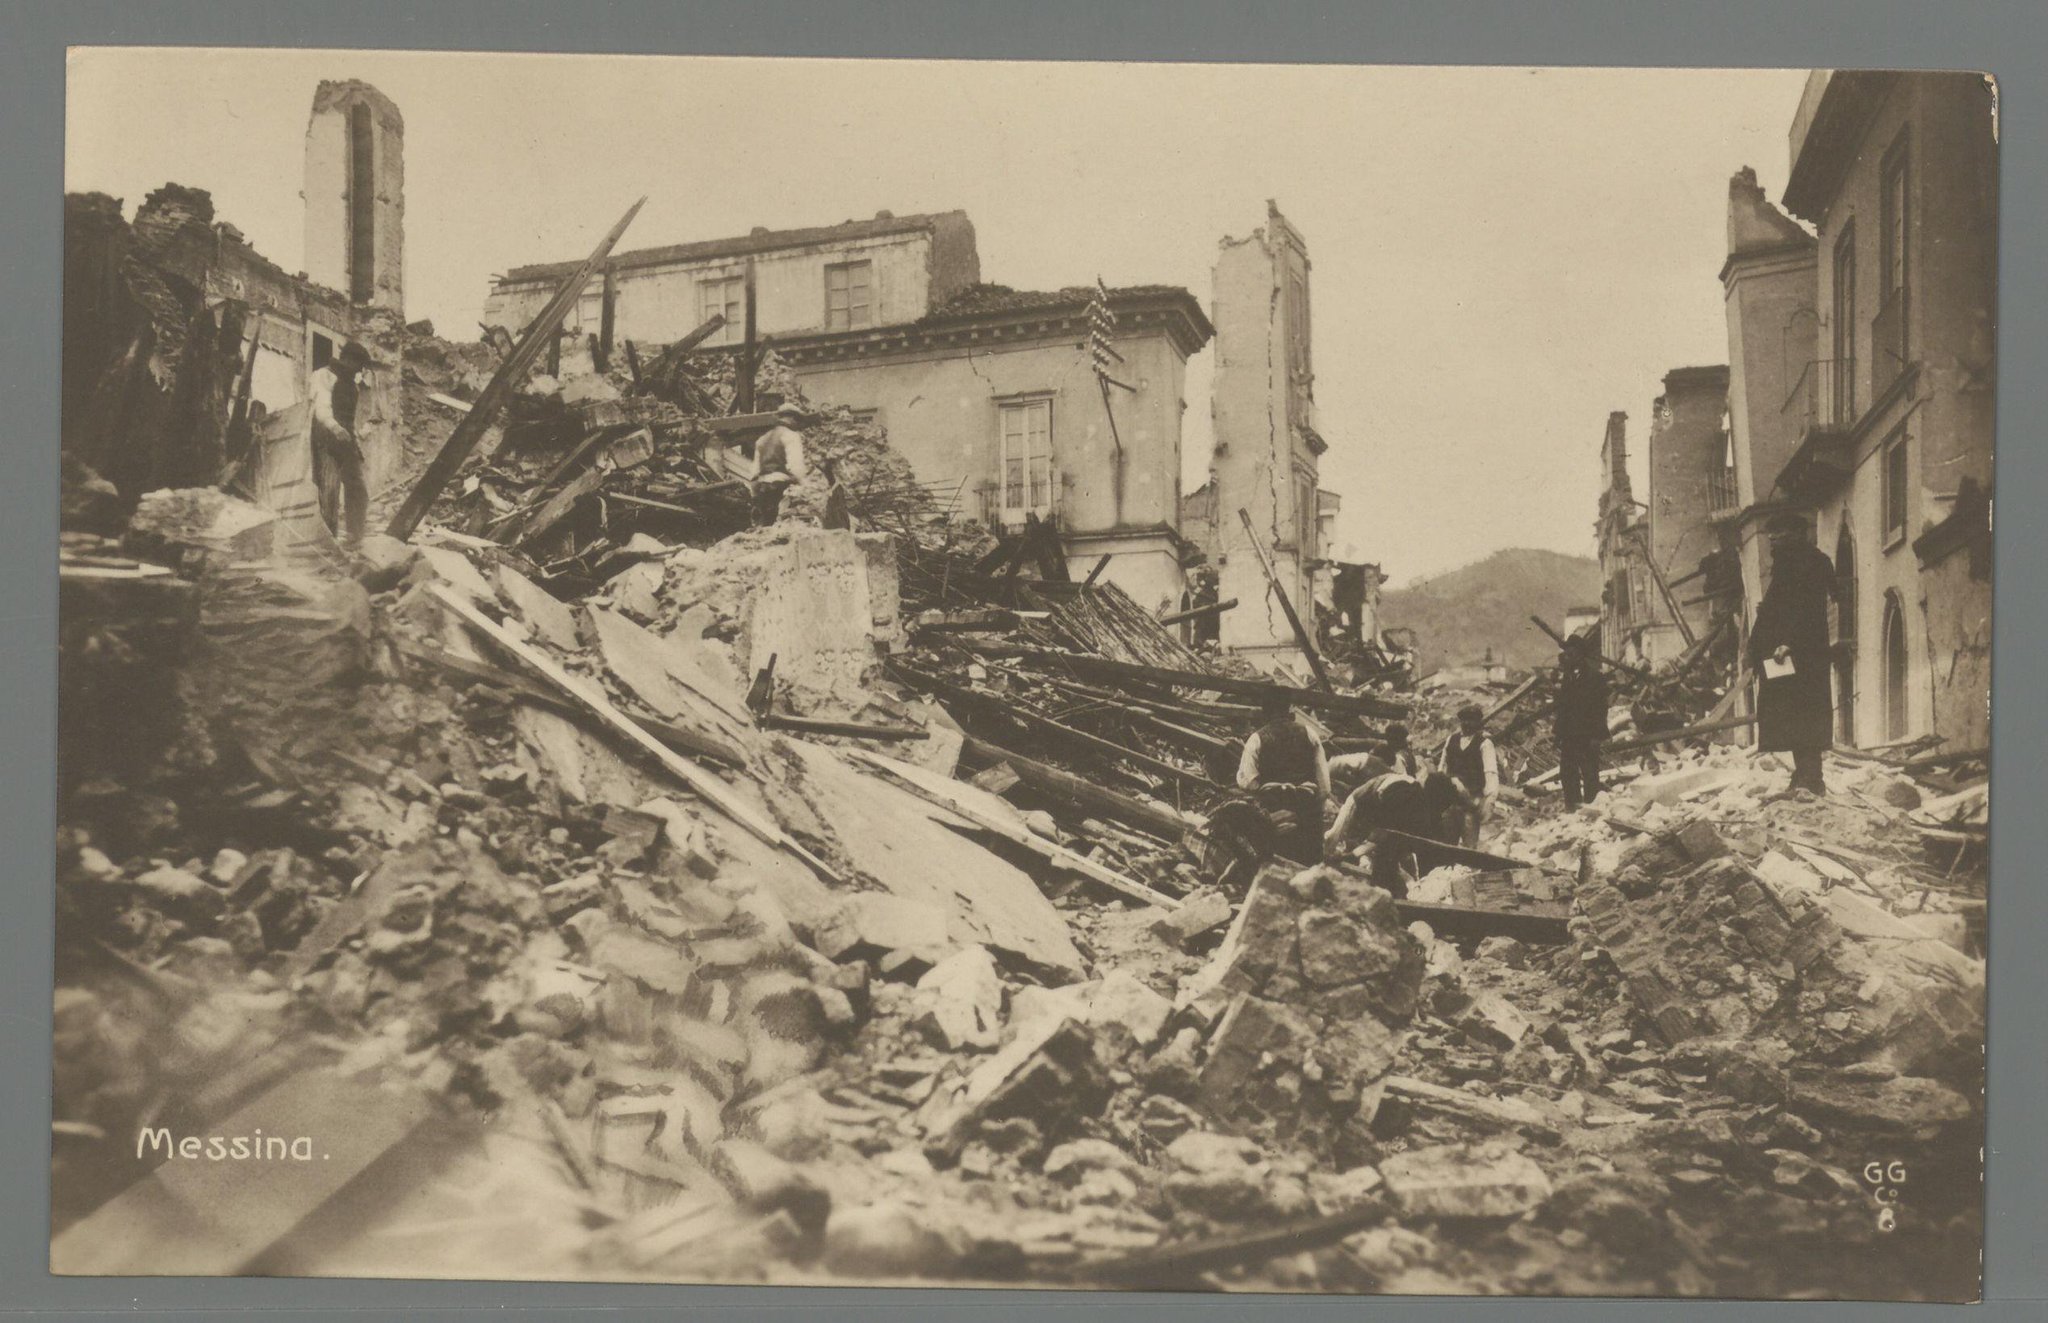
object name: ansichtkaart, prentbriefkaart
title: Messina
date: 1908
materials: paper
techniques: gelatin silver print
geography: berlin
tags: consequences of an earthquake, collapsing building, city-view, and landscape with man-made constructions (+ city(-scape) with figures, staffage)